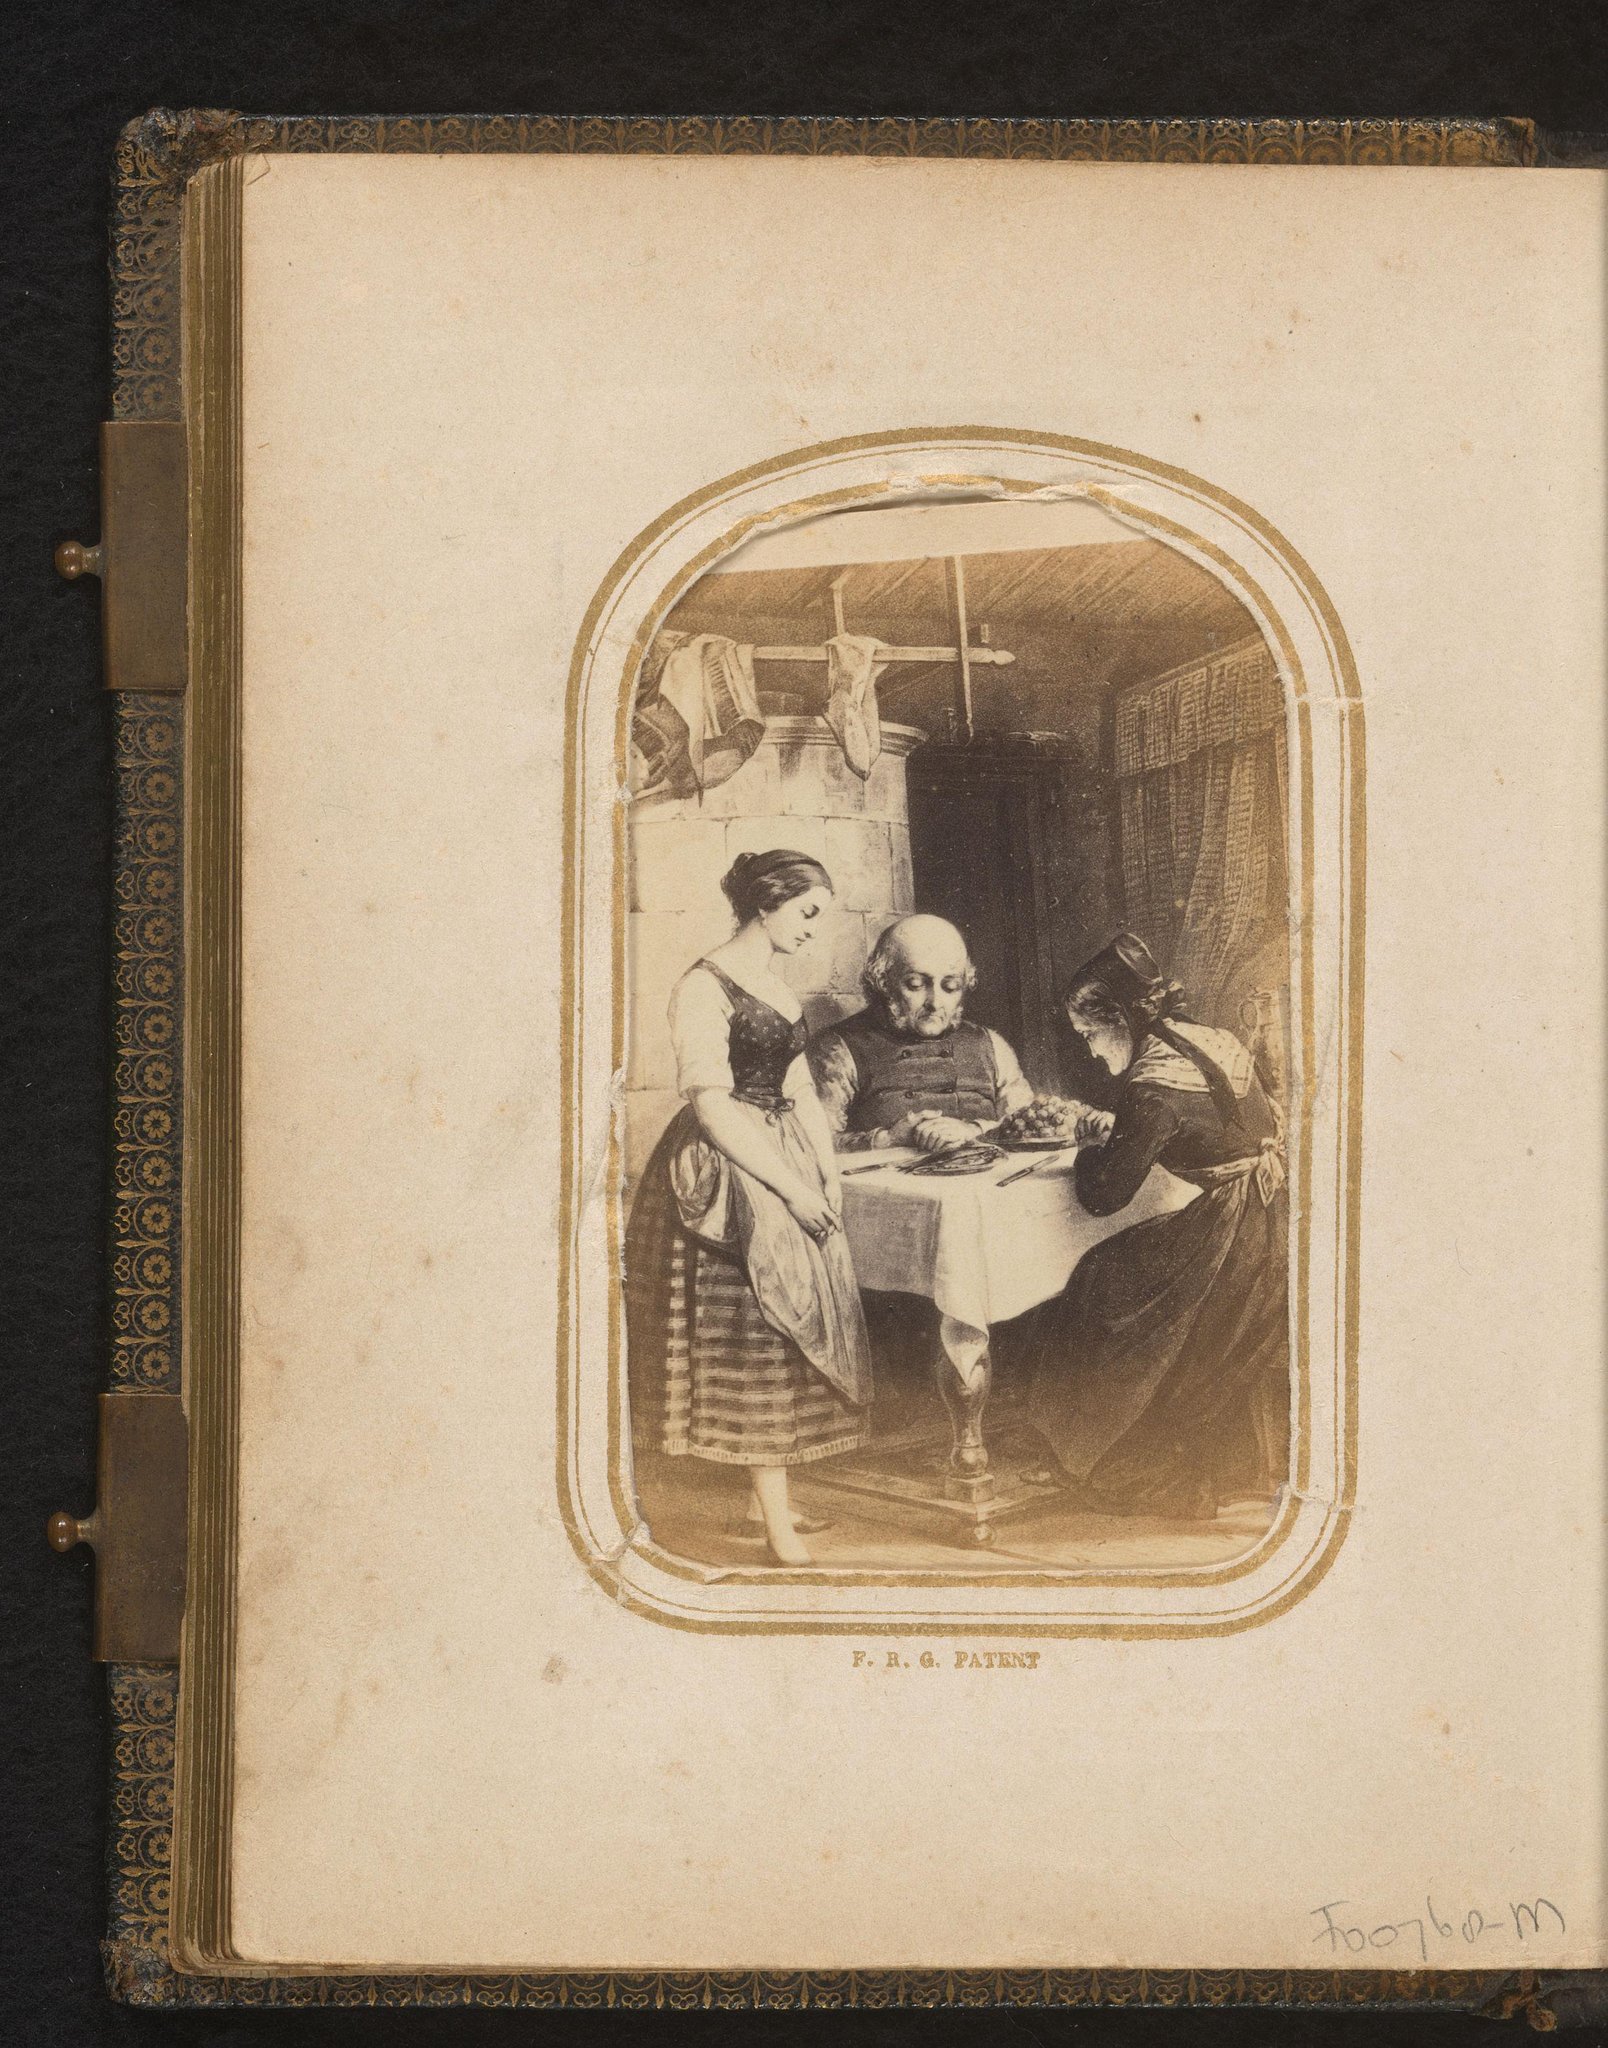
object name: album leaf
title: Fotoreproductie van een schilderij van een biddend gezin rond de tafel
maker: Anonymous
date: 1865-1890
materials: cardboard, photographic support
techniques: albumen print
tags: family life, interior of the house, prayer at table, saying grace, painting, drawing and the graphic arts